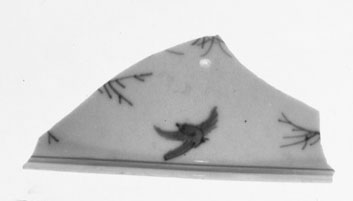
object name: fragment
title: Fragment of a Bowl (Study Collection)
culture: chinese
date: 1501-1600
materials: porcelain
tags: birds